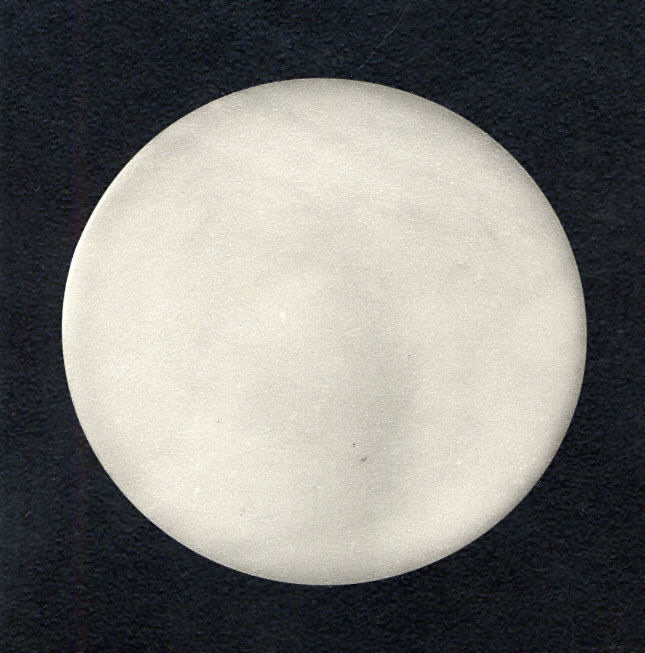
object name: disc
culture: chinese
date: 1801-1900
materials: ivory